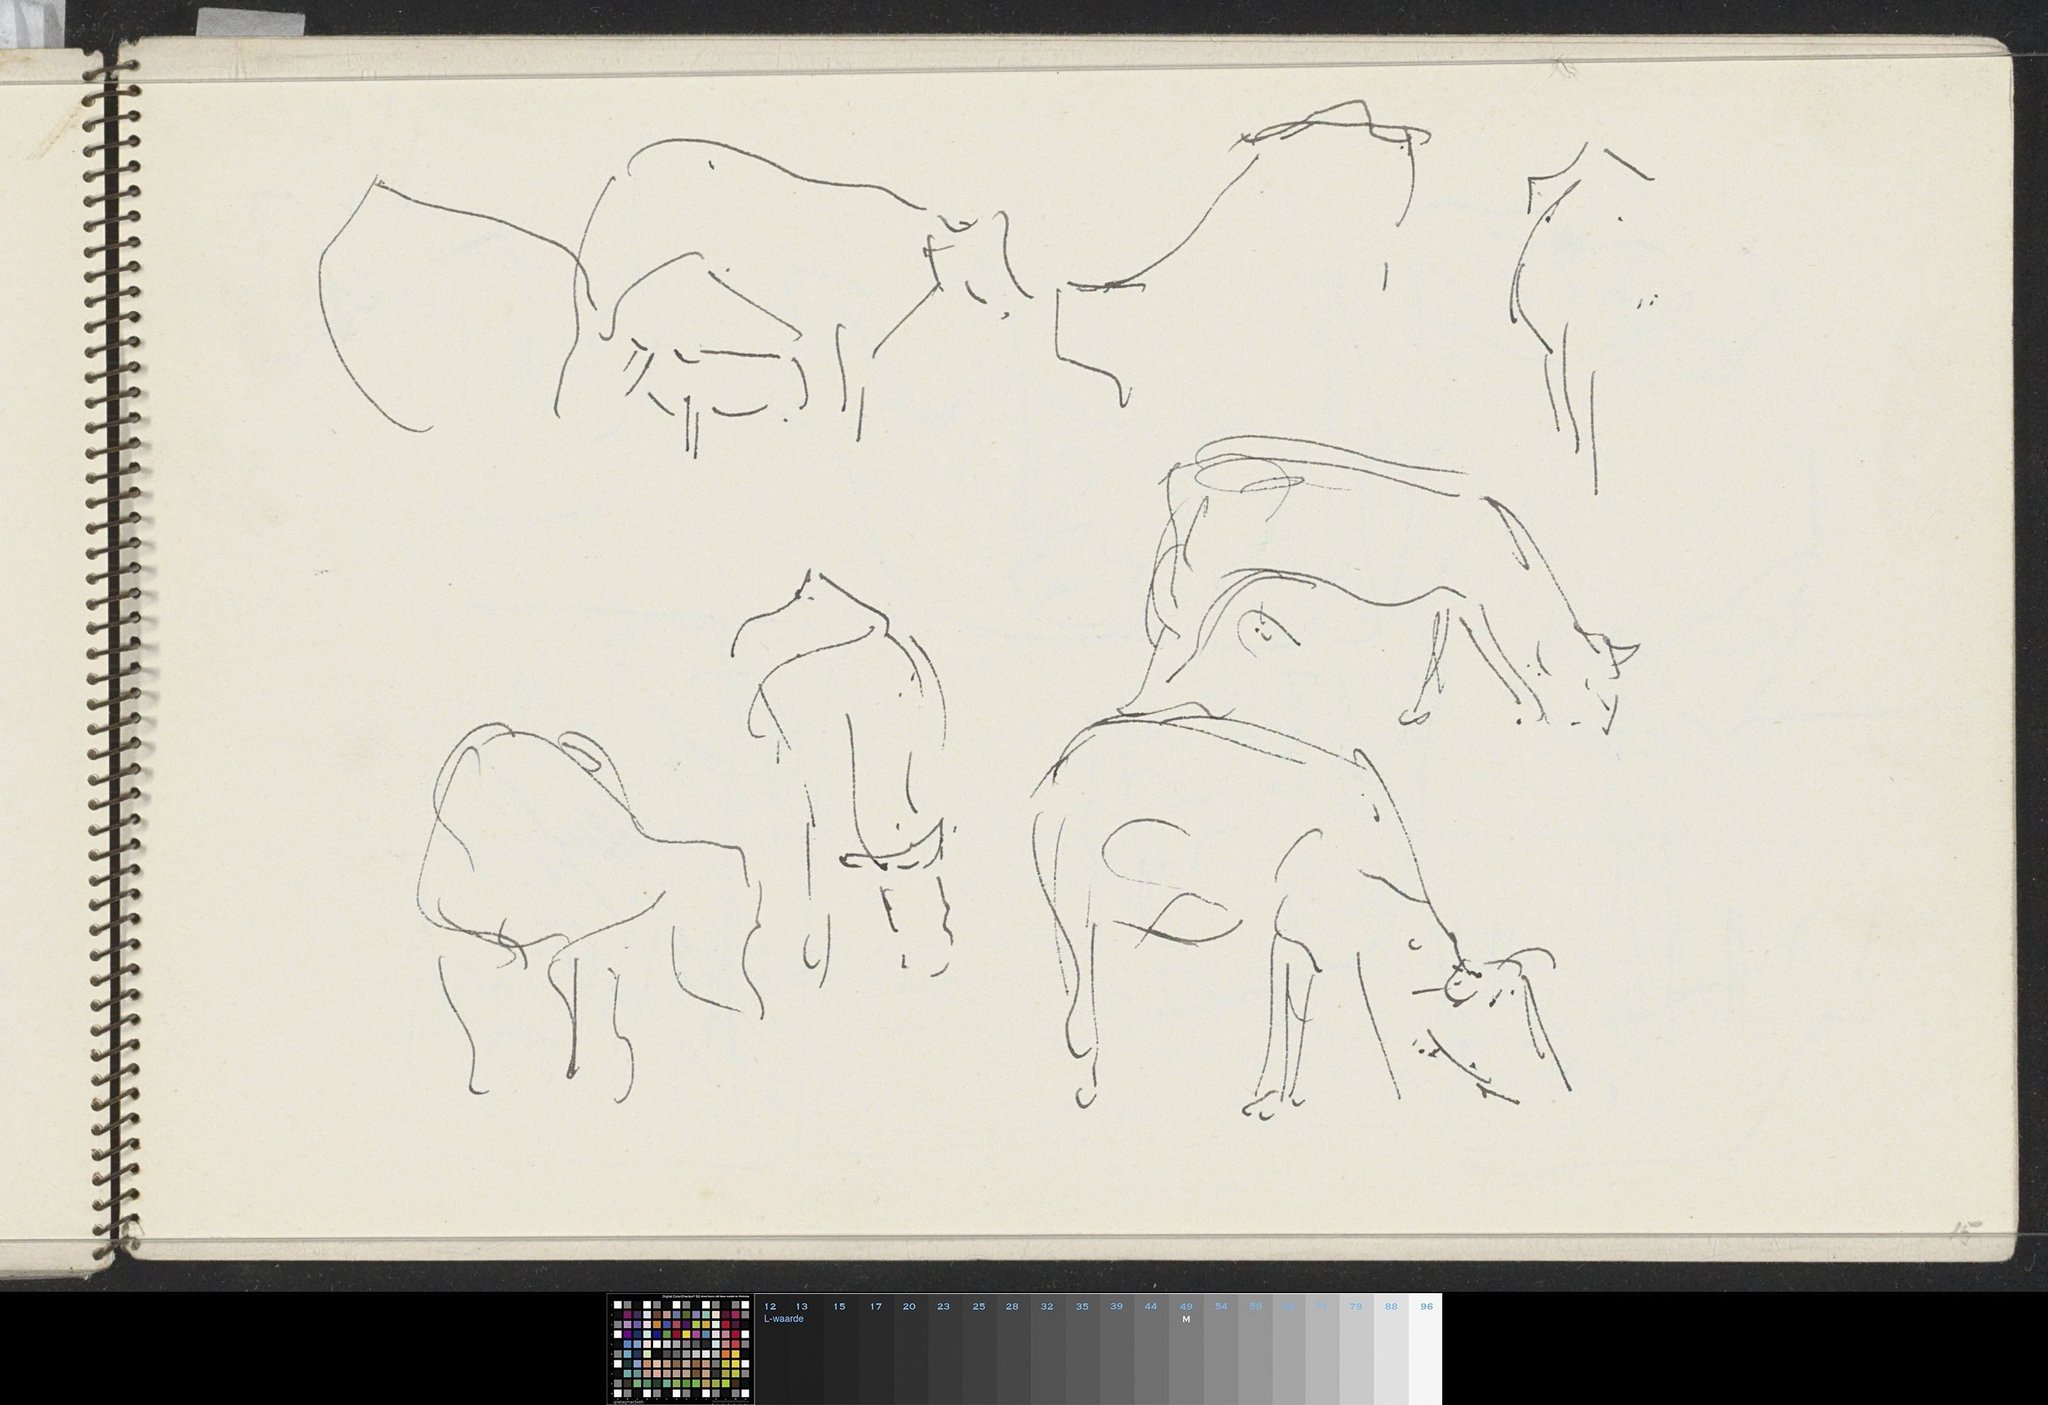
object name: sketchbook leaf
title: Koeien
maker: carel adolph lion cachet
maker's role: draughtsman, print maker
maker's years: 1864-1945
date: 1930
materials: ink, paper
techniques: pen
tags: cow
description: Blad 16 recto uit een schetsboek met 20 bladen.